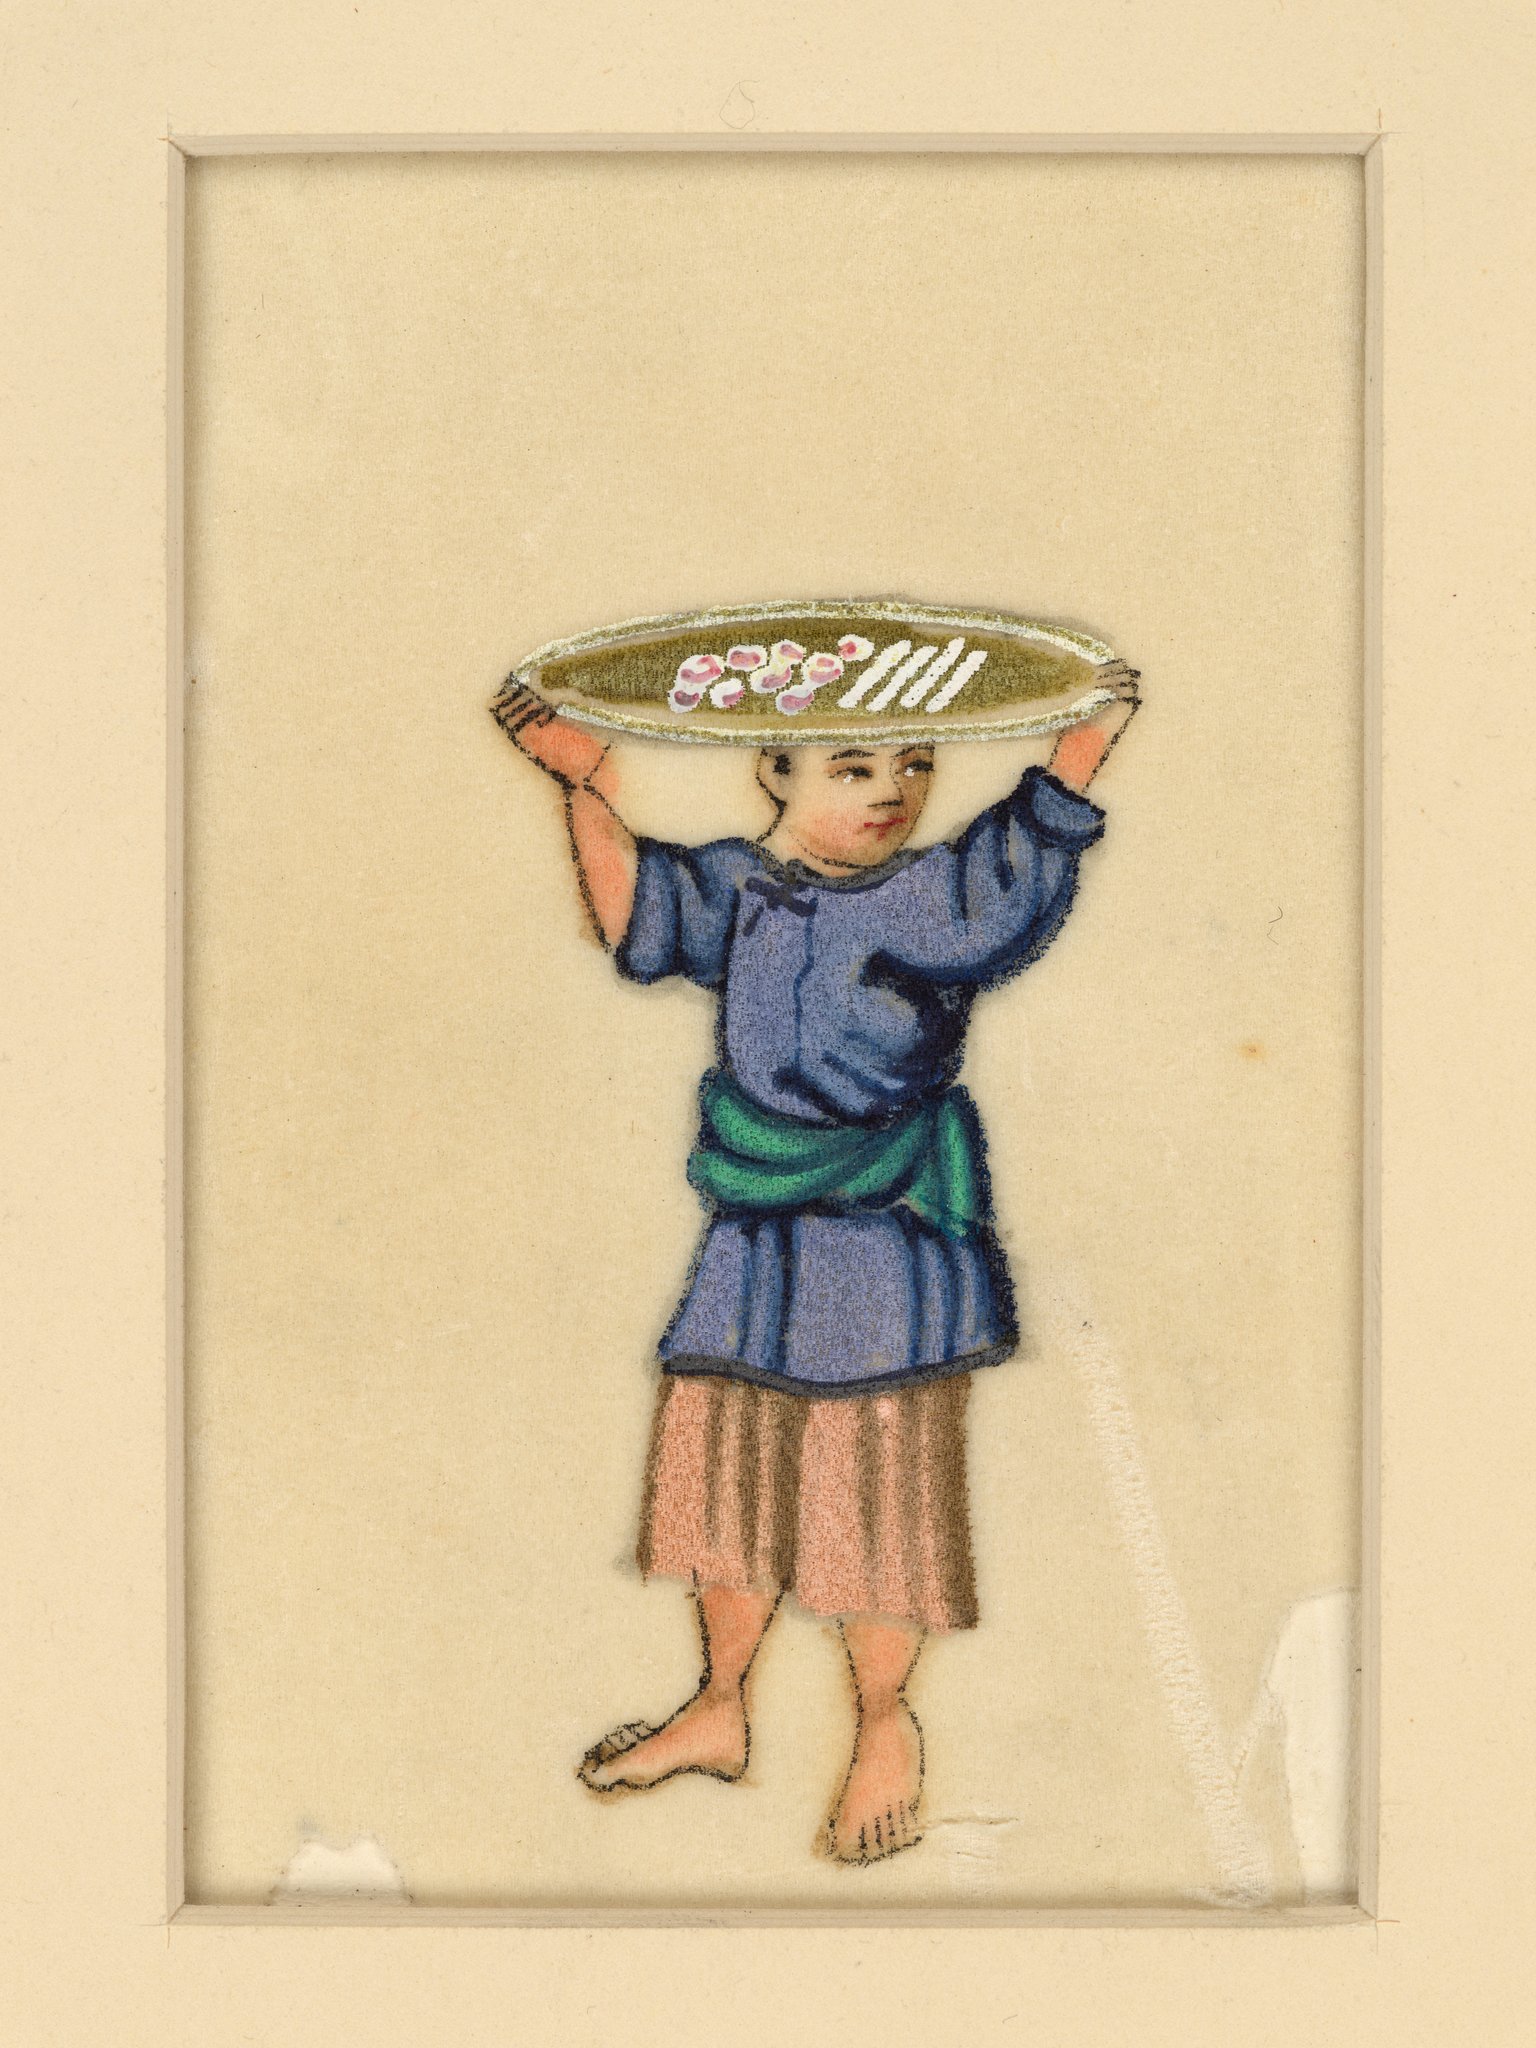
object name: leaf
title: Fisherman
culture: chinese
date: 1901-1933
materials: paper